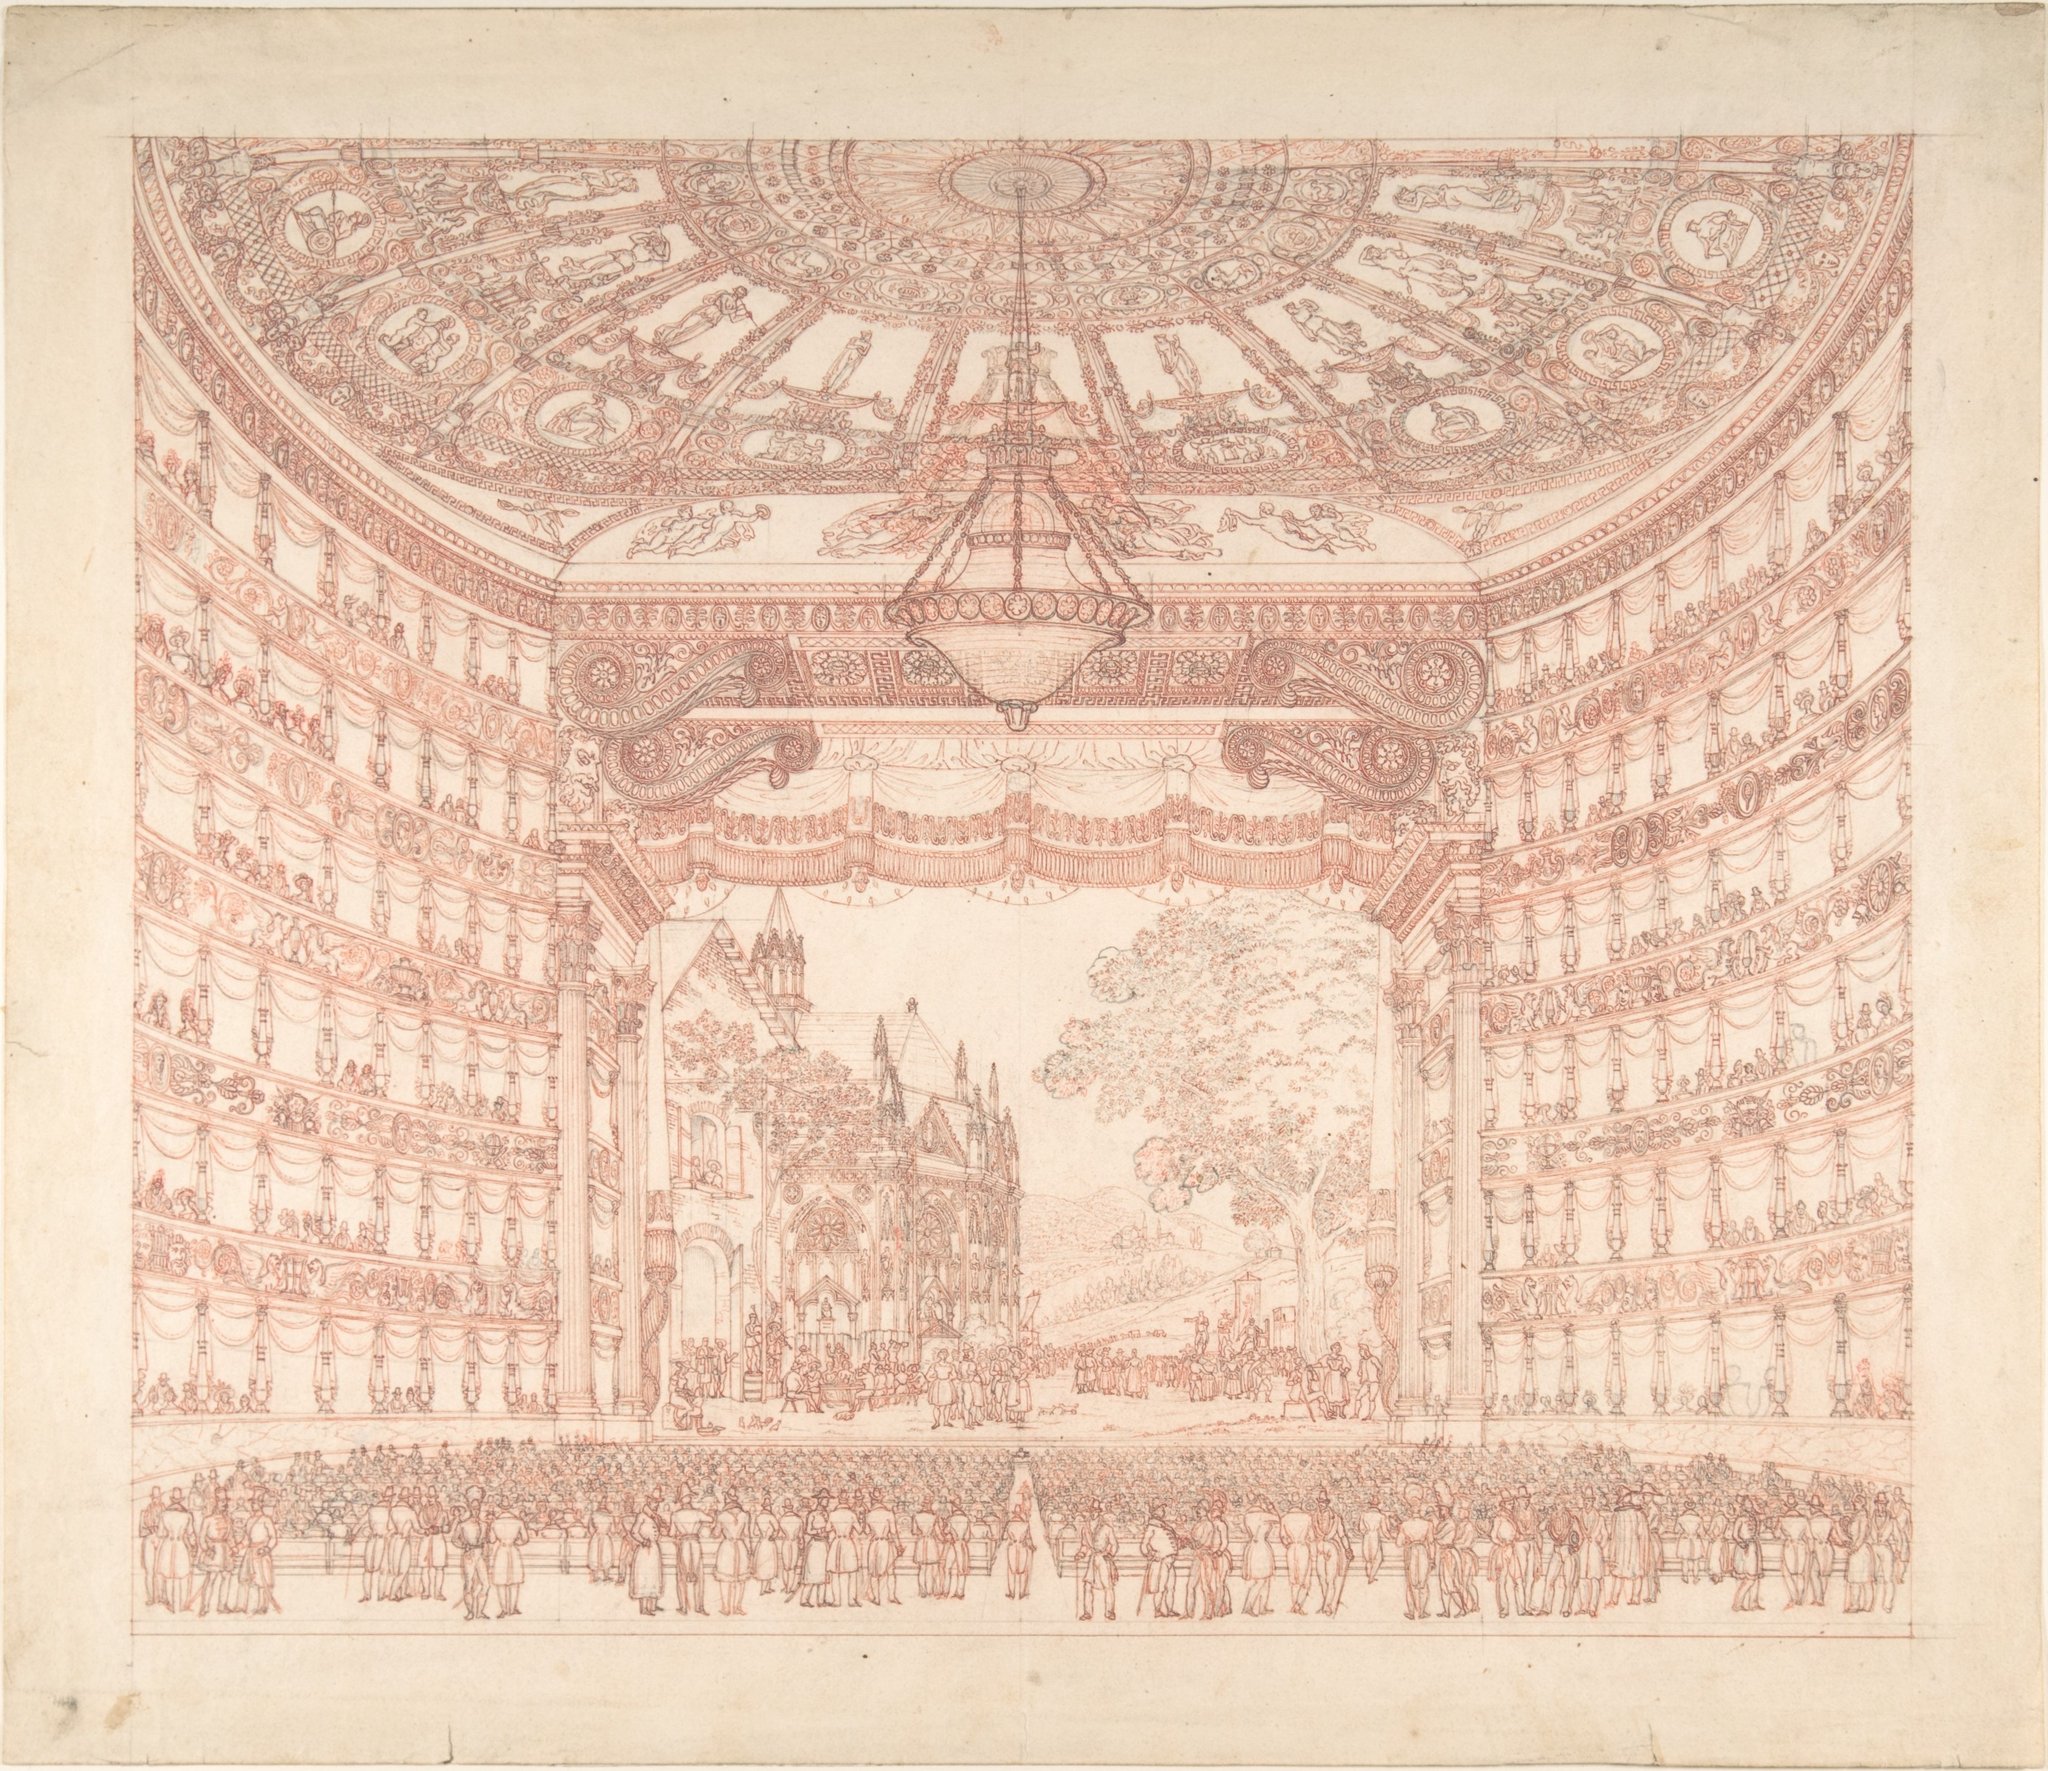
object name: drawing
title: Stage Set with Peasants Meeting in Village Setting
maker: anonymous, italian, 19th century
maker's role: artist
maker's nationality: italian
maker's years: 1800-1900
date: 1801-1900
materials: ink, pencil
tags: theatre,interiors,crowd,stage design